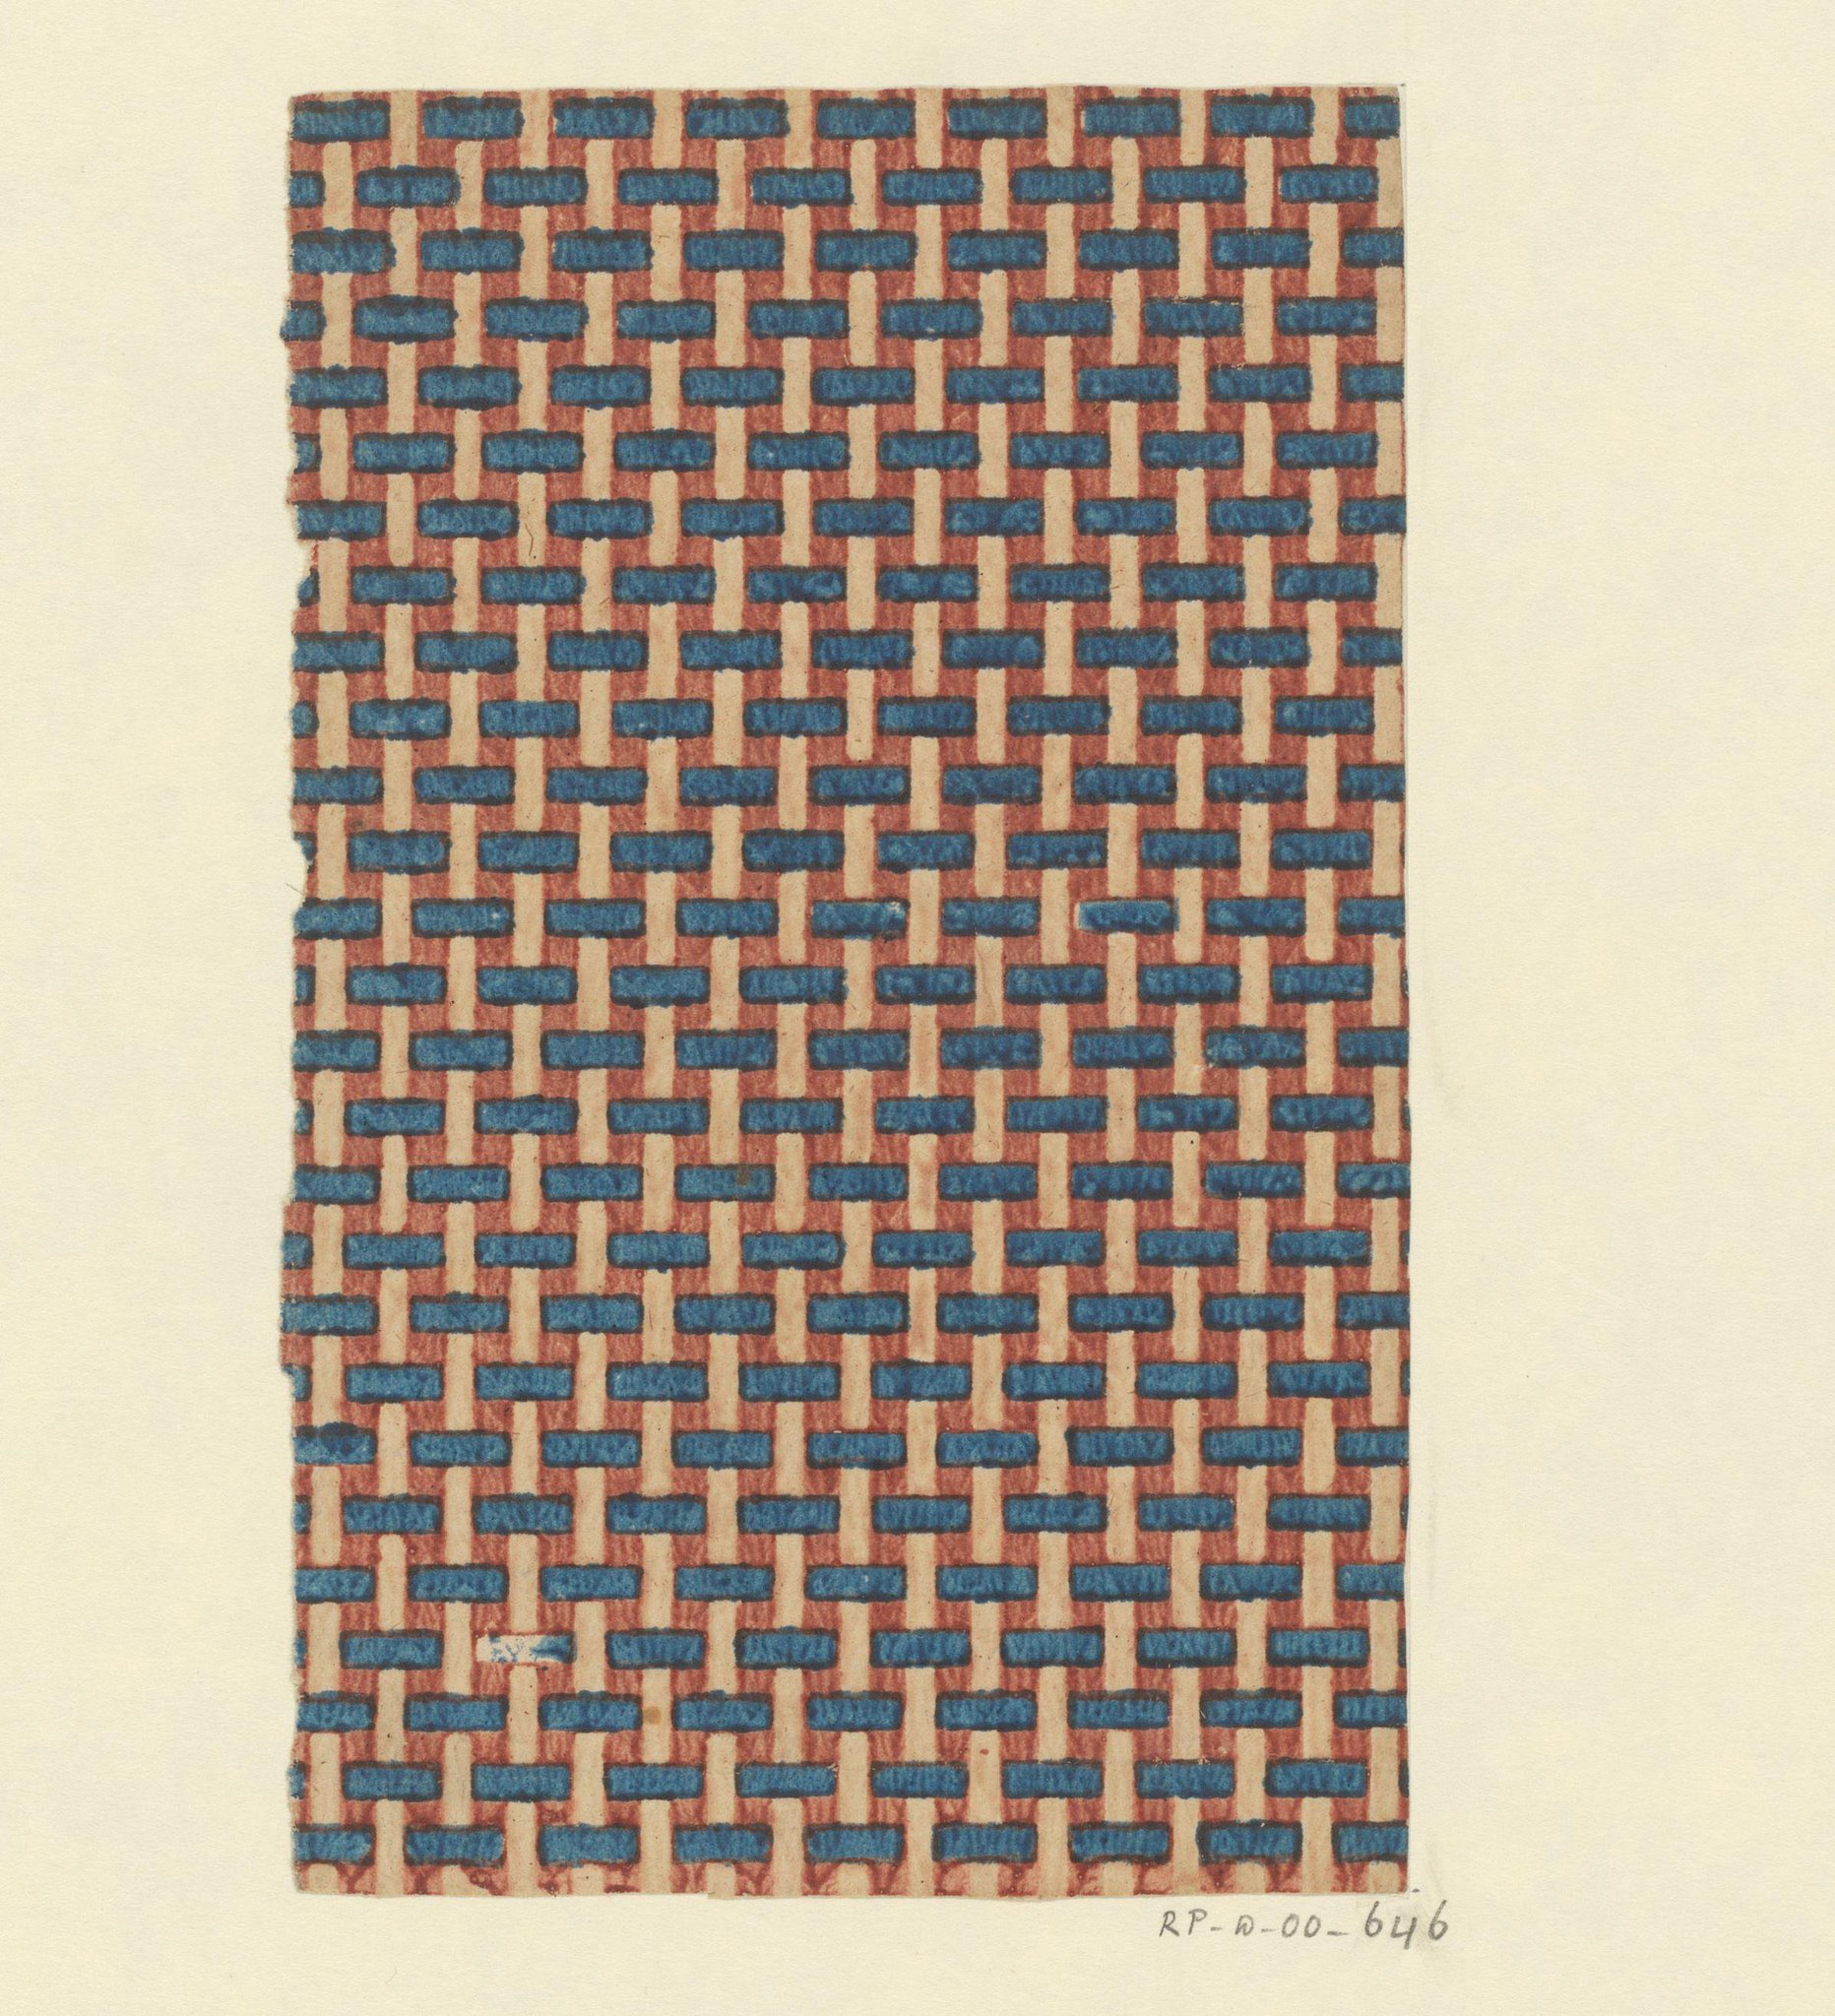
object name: printed paper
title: Blaad met banenpatroon van gevlochten lijnen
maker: Anonymous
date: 1750-1900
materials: paper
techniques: printing block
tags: ornament ~ geometric motifs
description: Blaad met rechthoekig banenpatroon van gevlochten lijnen.